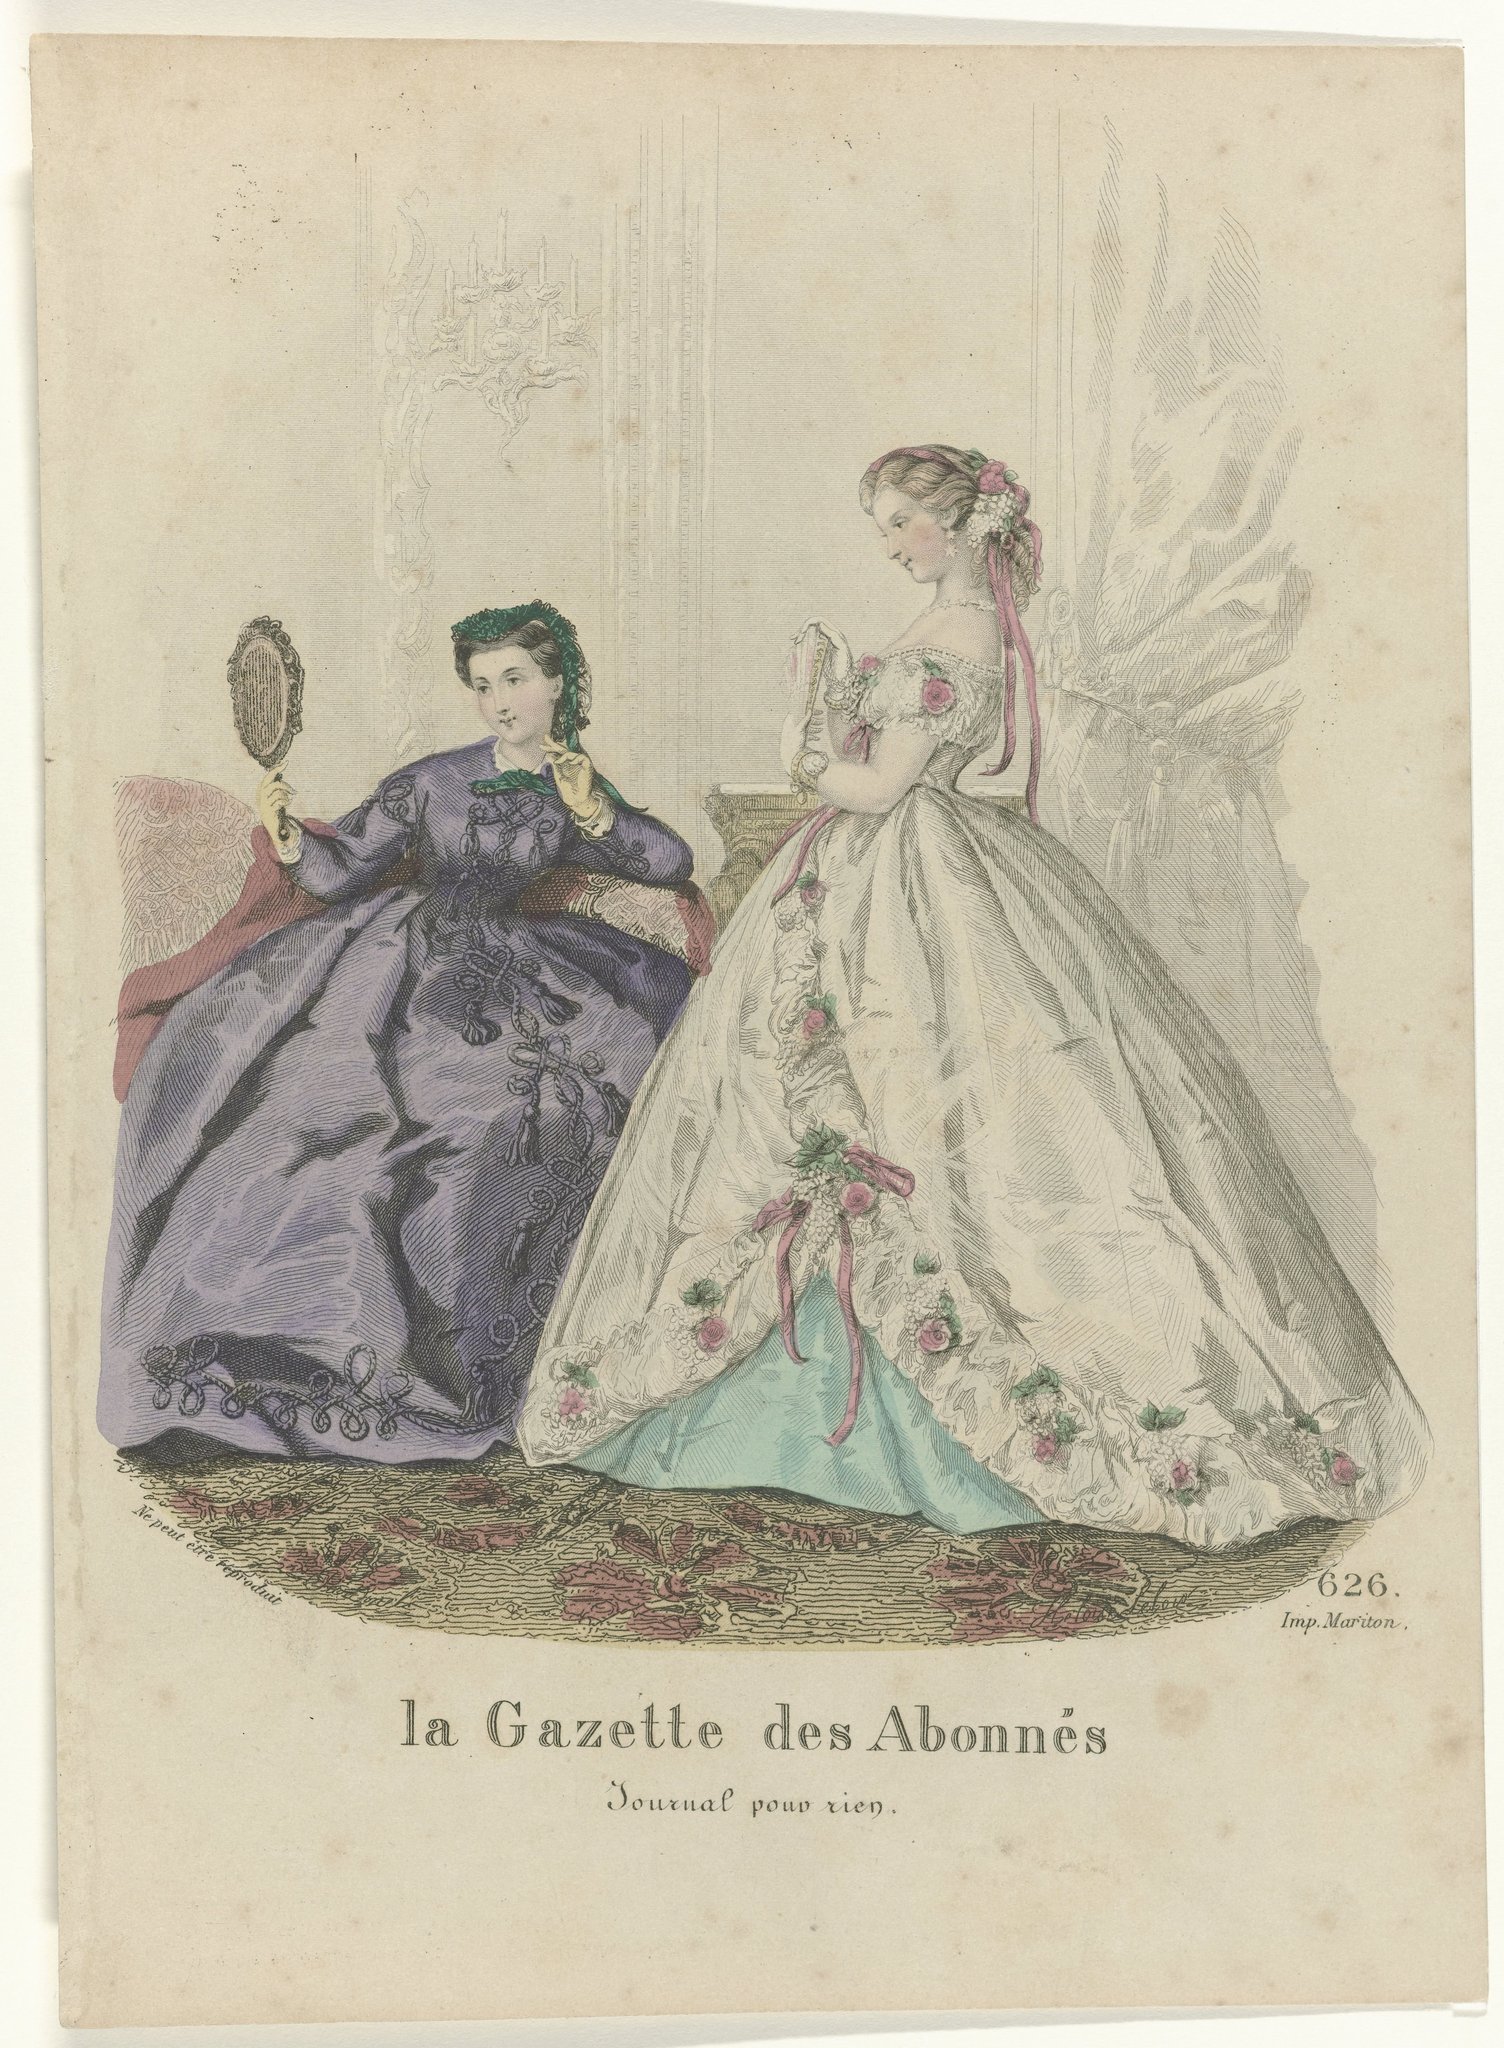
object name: fashion print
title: La Gazette des Abbonés, Journal pour rien, 1865, No. 626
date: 1865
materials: paper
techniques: engraving, hand coloring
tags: looking in the mirror; (possibly: contemplation of own beauty - aa - (for) women), cut flowers; nosegay, bunch of flowers, underclothes for the lower part of the body (underskirt) (+ women's clothes), fashion plates, fan (+ women's clothes), bracelet, wristlet (+ women's clothes), necklace (+ women's clothes)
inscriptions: title: ‘la Gazette des Abonnés / Journal pour rien.’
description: Twee jonge vrouwen in een interieur. Eén van hen, in paarse japon met passementen, zit op een sofa en bekijkt zichtzelf in een handspiegel. De staande vrouw draagt een witte avondjapon over een turquoise onderrok en heeft een dichtgeklapte waaier in de hand.